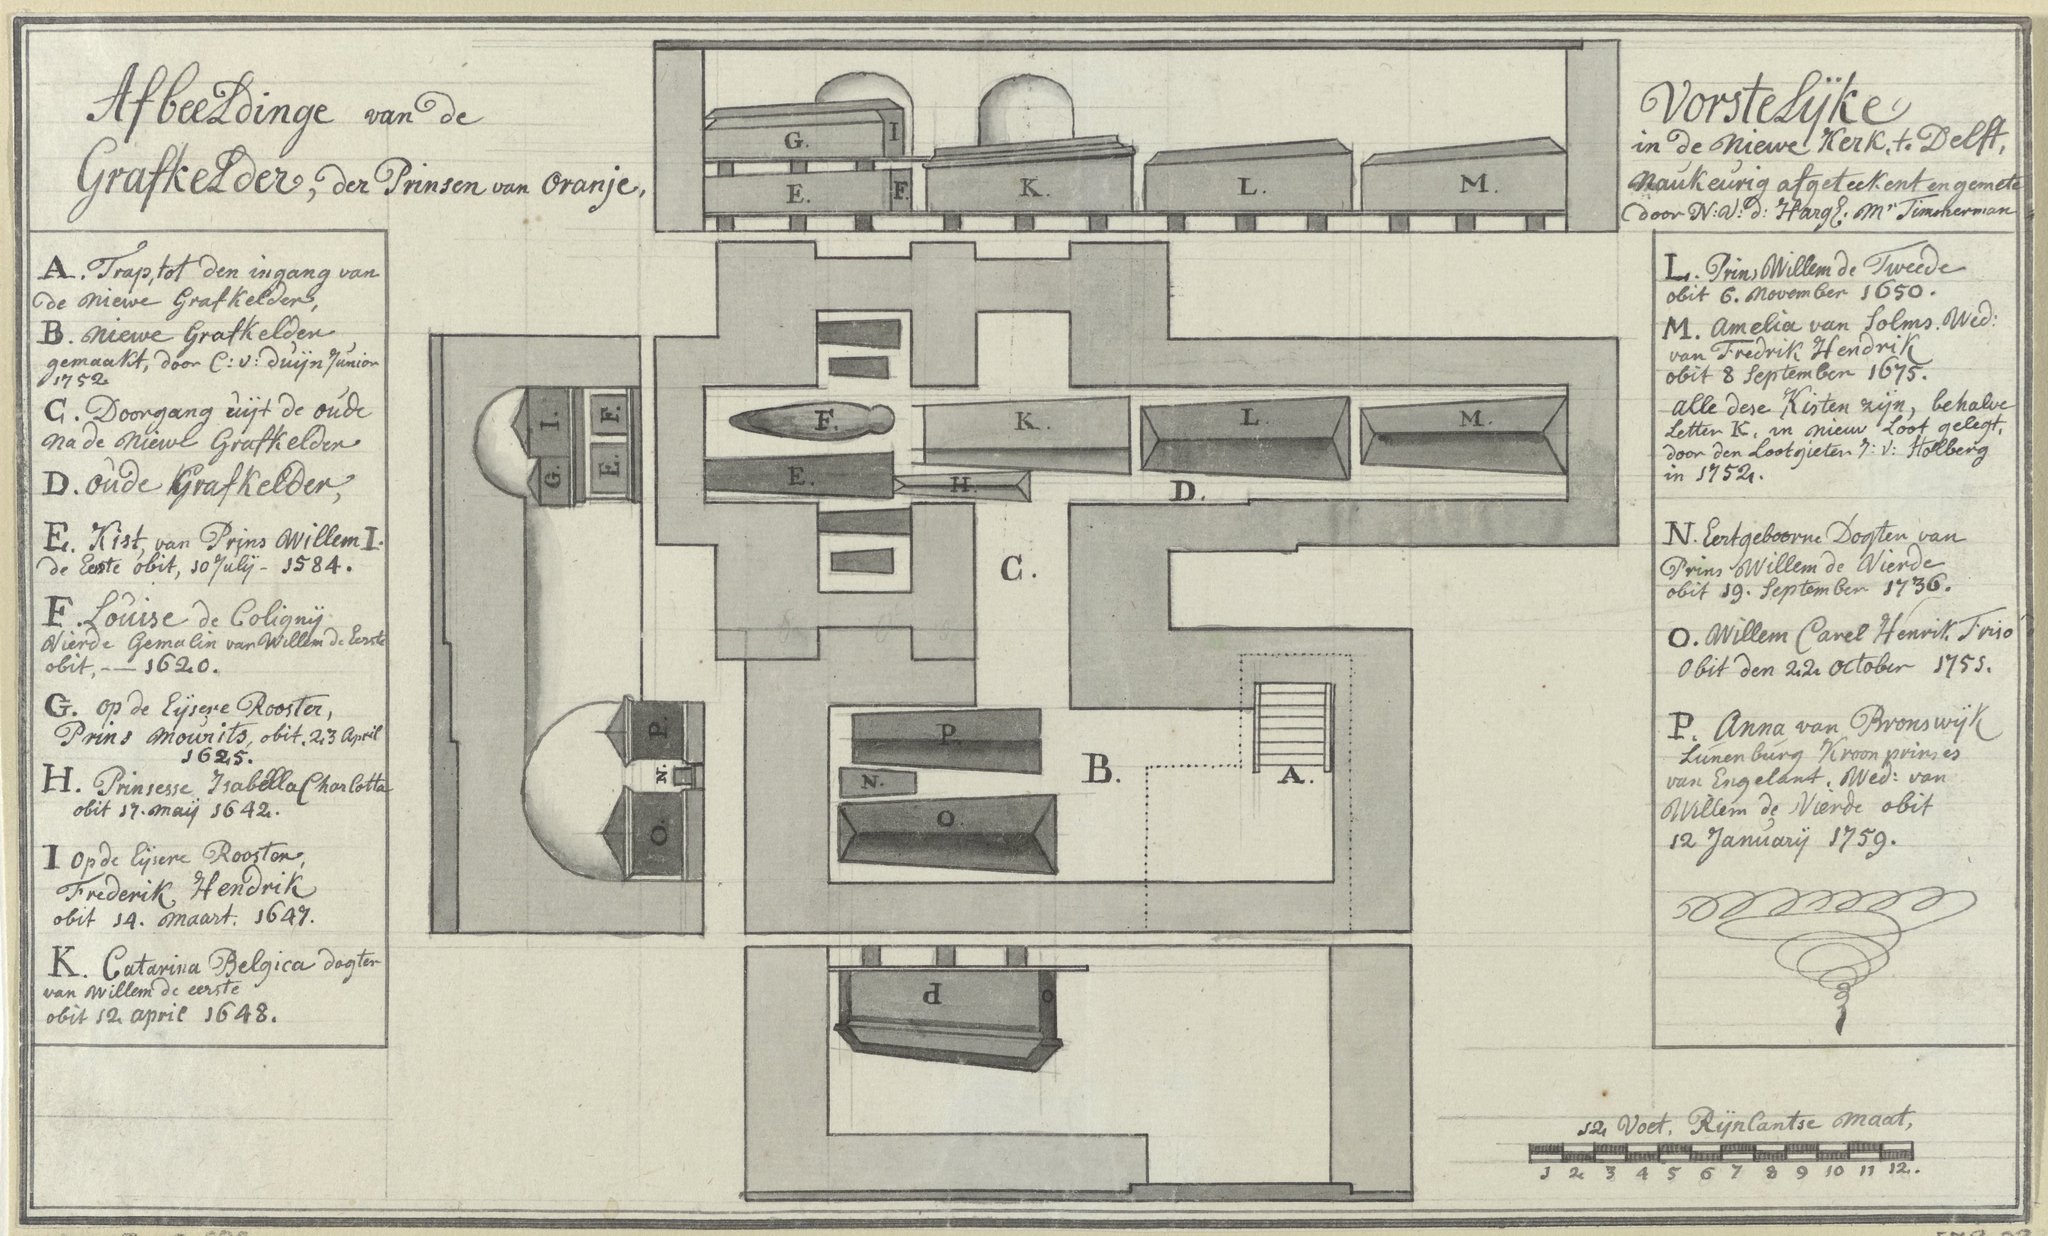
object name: drawing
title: Plattegrond van de grafkelder van het Huis Oranje-Nassau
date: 1767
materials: ink, paper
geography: low countries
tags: interior of church, grave-building, monumental tomb, delft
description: Plattegrond en doorsneden van de grafkelder van het Huis Oranje-Nassau onder de Nieuwe Kerk te Delft met de daarin geplaatste kisten, voorzien van letters. In een kader een verklarende lijst.